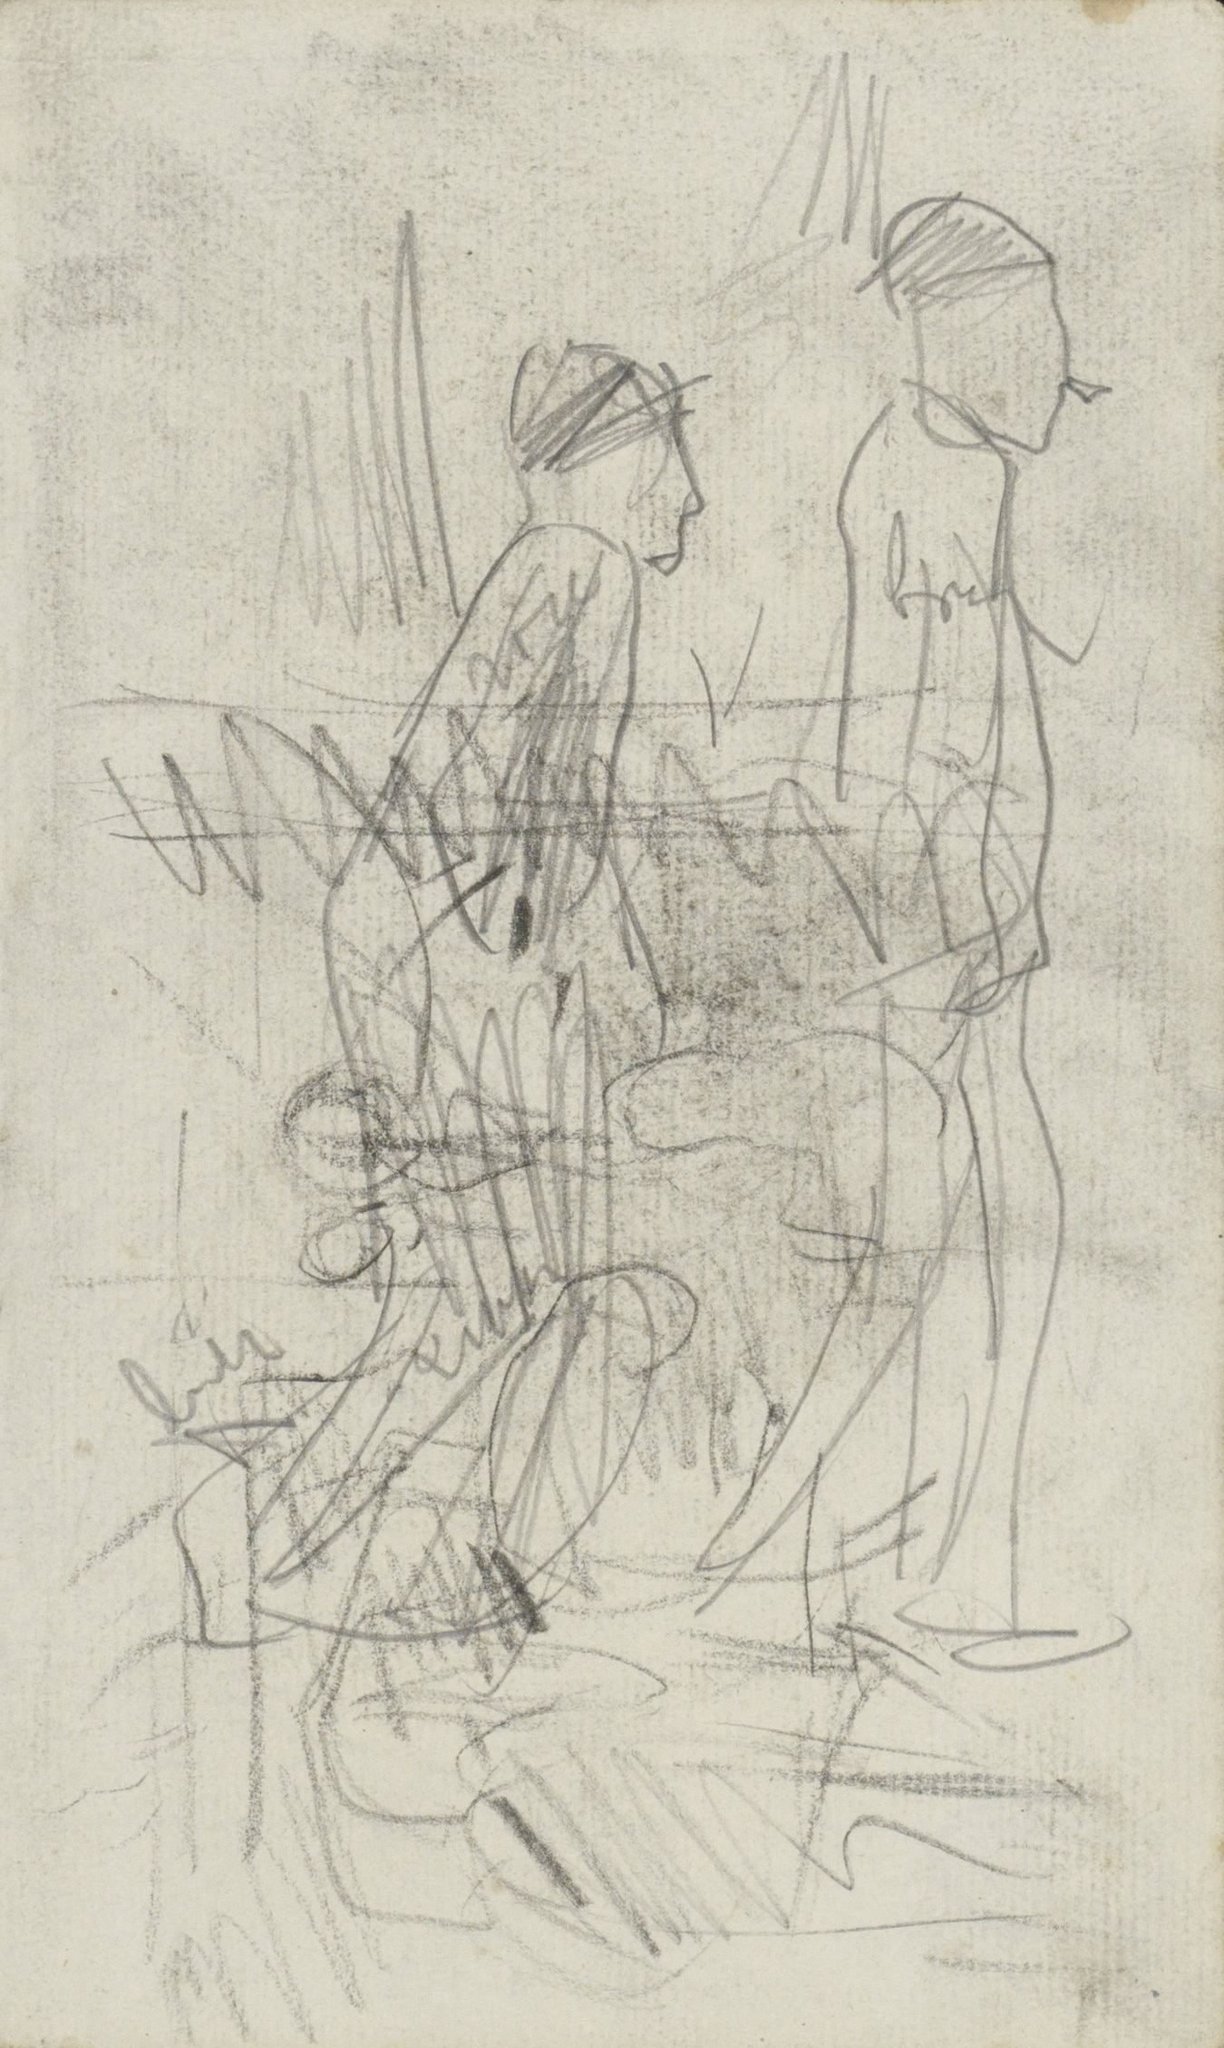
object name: drawing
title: Twee staande mannen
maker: george hendrik breitner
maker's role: draughtsman, painter, print maker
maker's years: 1857-1923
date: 1873-1923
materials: chalk, paper, pencil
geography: the hague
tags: standing figure (+ sideview, profile), cigarette (+ taking (particular) foodstuffs: eating, drinking, smoking, chewing, etc.)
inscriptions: workshop stamp: Lugt 291d, collector's mark: Lugt 2228